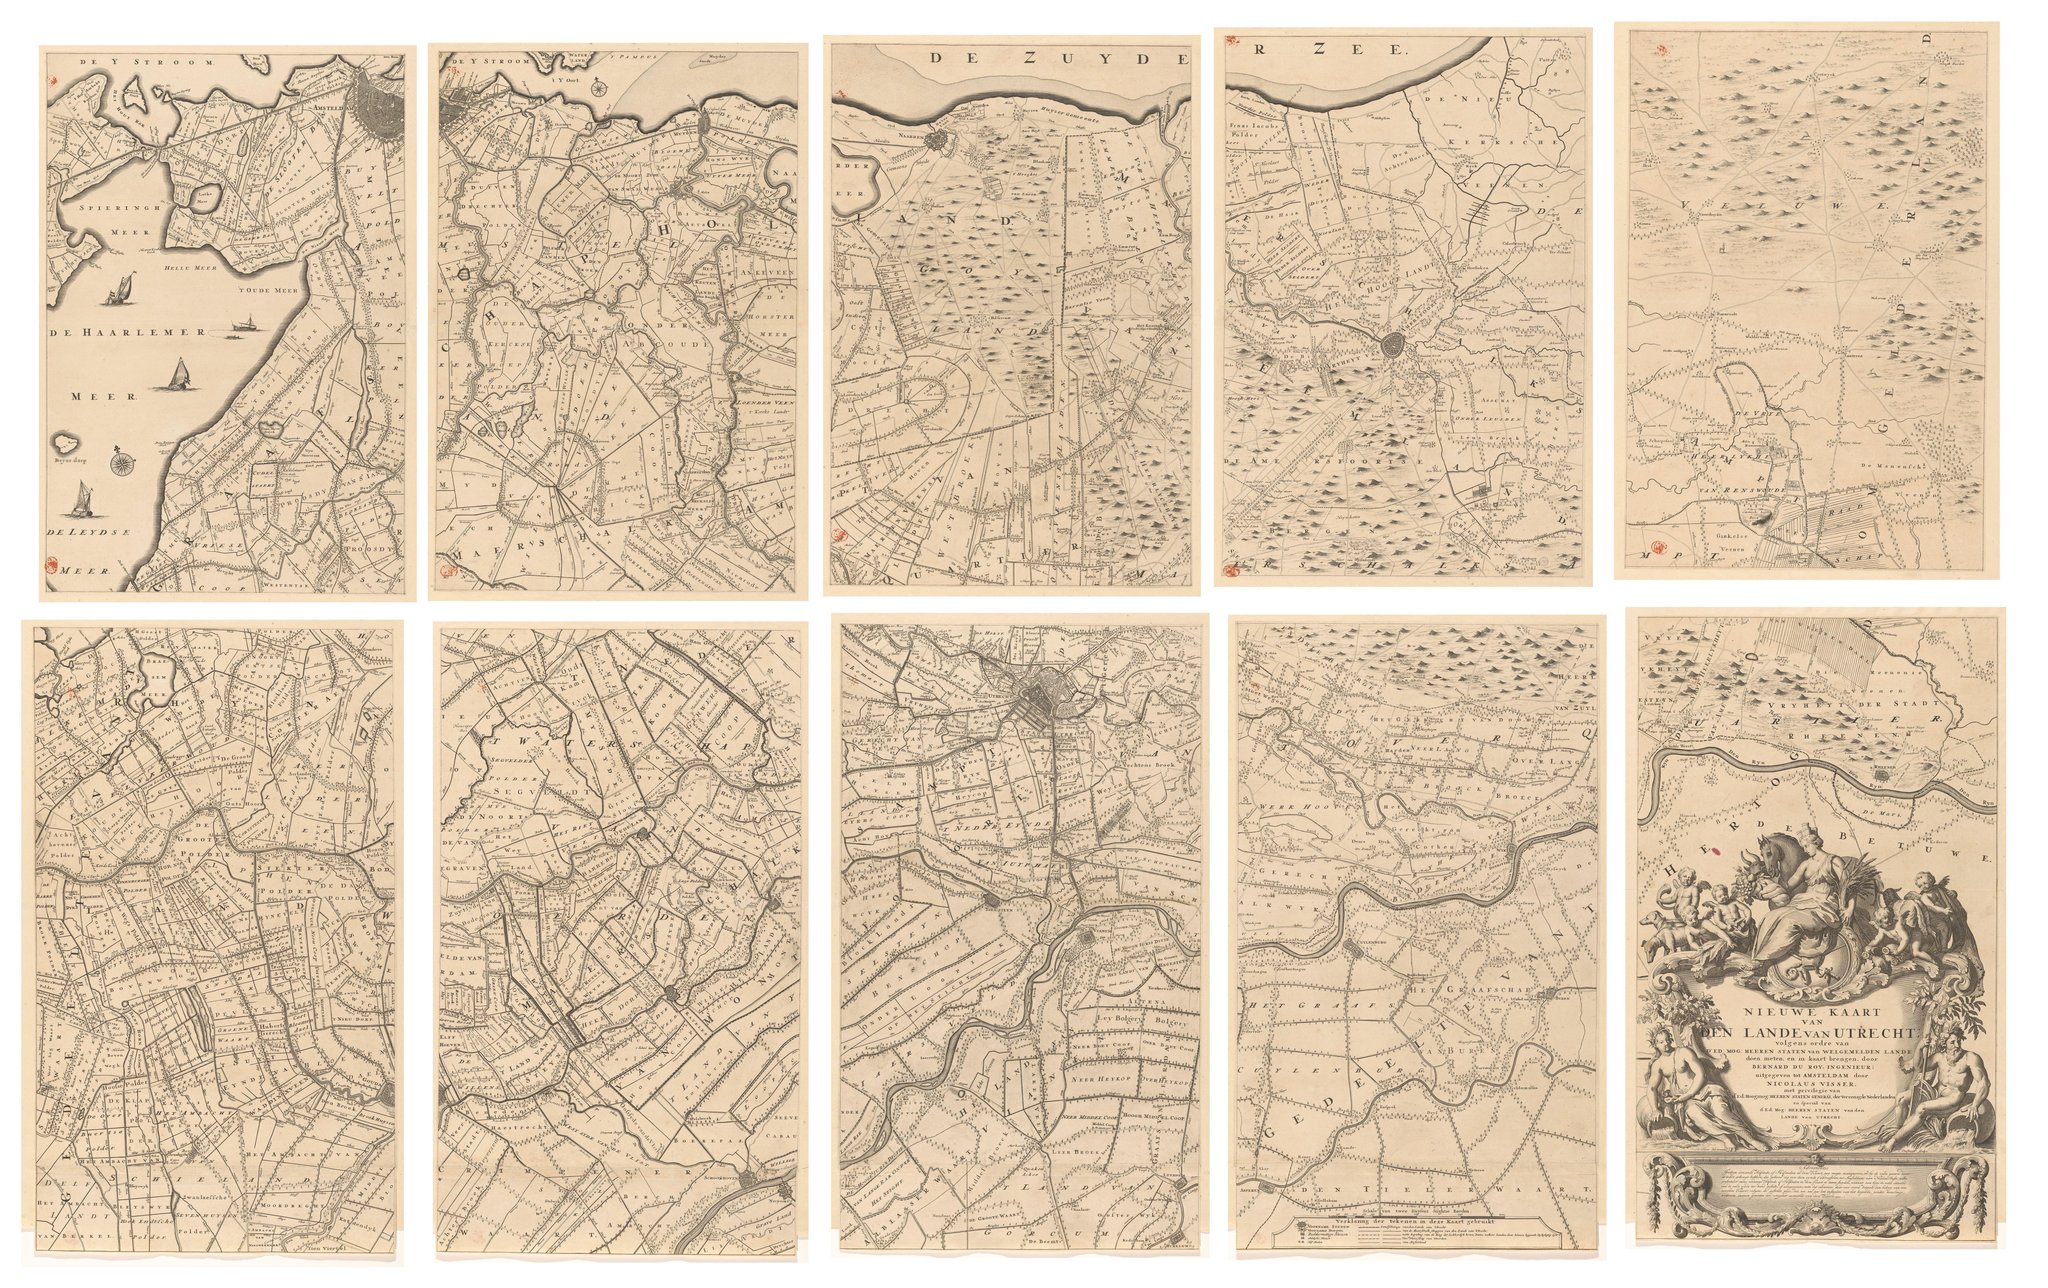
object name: print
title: Nieuwe kaart van den lande van Utrecht (...)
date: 1696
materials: paper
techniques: engraving, etching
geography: utrecht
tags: coat of arms (as symbol of the state, etc.), peat-cutting, maps of separate countries or regions, hunting, chase, cattle, river-gods, fishing (sports), agriculture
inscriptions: collector's mark: Lugt 195, collector's mark: Lugt 195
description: Dit object is omwille van een betere presentatie virtueel samengevoegd maar bestaat fysiek uit losse onderdelen. In de literatuur is altijd verondersteld dat er vier staten van deze kaart bestonden en dat de gewijzigde titel en inhoud van de titelcartouche, advertentie onder de cartouche, schaalstok links van de cartouche en andere wijzigingen op de kaart op de veronderstelde tweede staat in 1743 zouden zijn aangebracht door Covens & Mortier. Het huidige exemplaar is echter een tot dusver onbekende tussenstaat die niet alleen aantoont dat de genoemde veranderingen eerder zijn aangebracht, maar ook dat deze tweede staat is uitgegeven door Nicolaes Visscher II, de uitgever van de eerste staat.